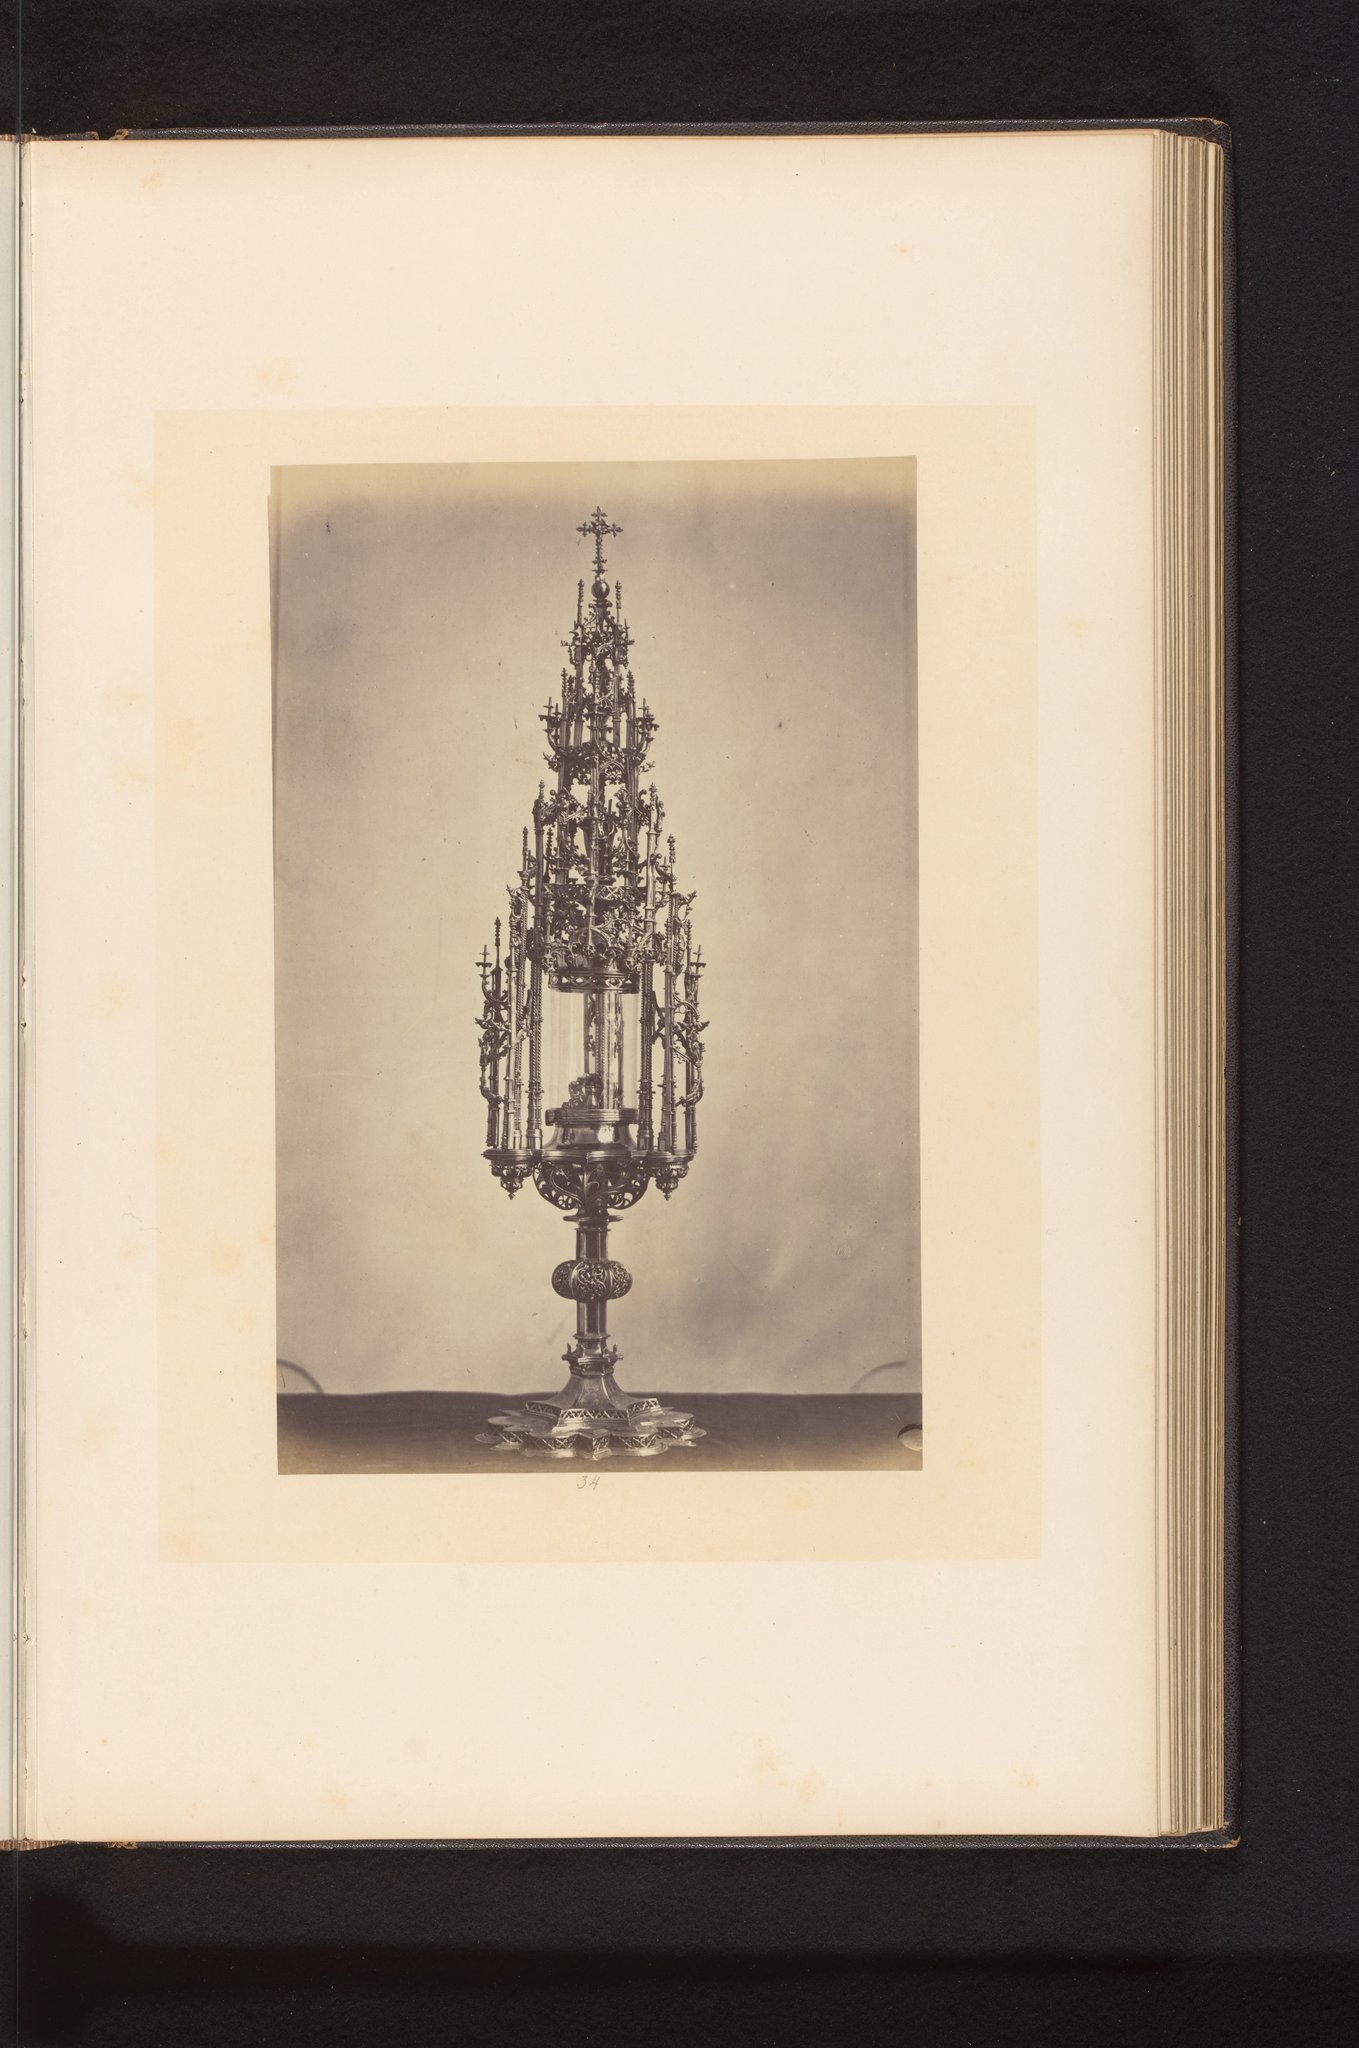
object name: photograph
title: Vergulde monstrans uit de Sint-Jakobskerk in Leuven, opgesteld op een tentoonstelling over religieuze objecten uit de middeleeuwen en renaissance in 1864 in Mechelen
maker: joseph maes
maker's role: fotograaf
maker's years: 1838-1908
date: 1864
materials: photographic support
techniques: albumen print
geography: mechelen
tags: ostensorium, monstrance, mechelen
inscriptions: number: ‘34’